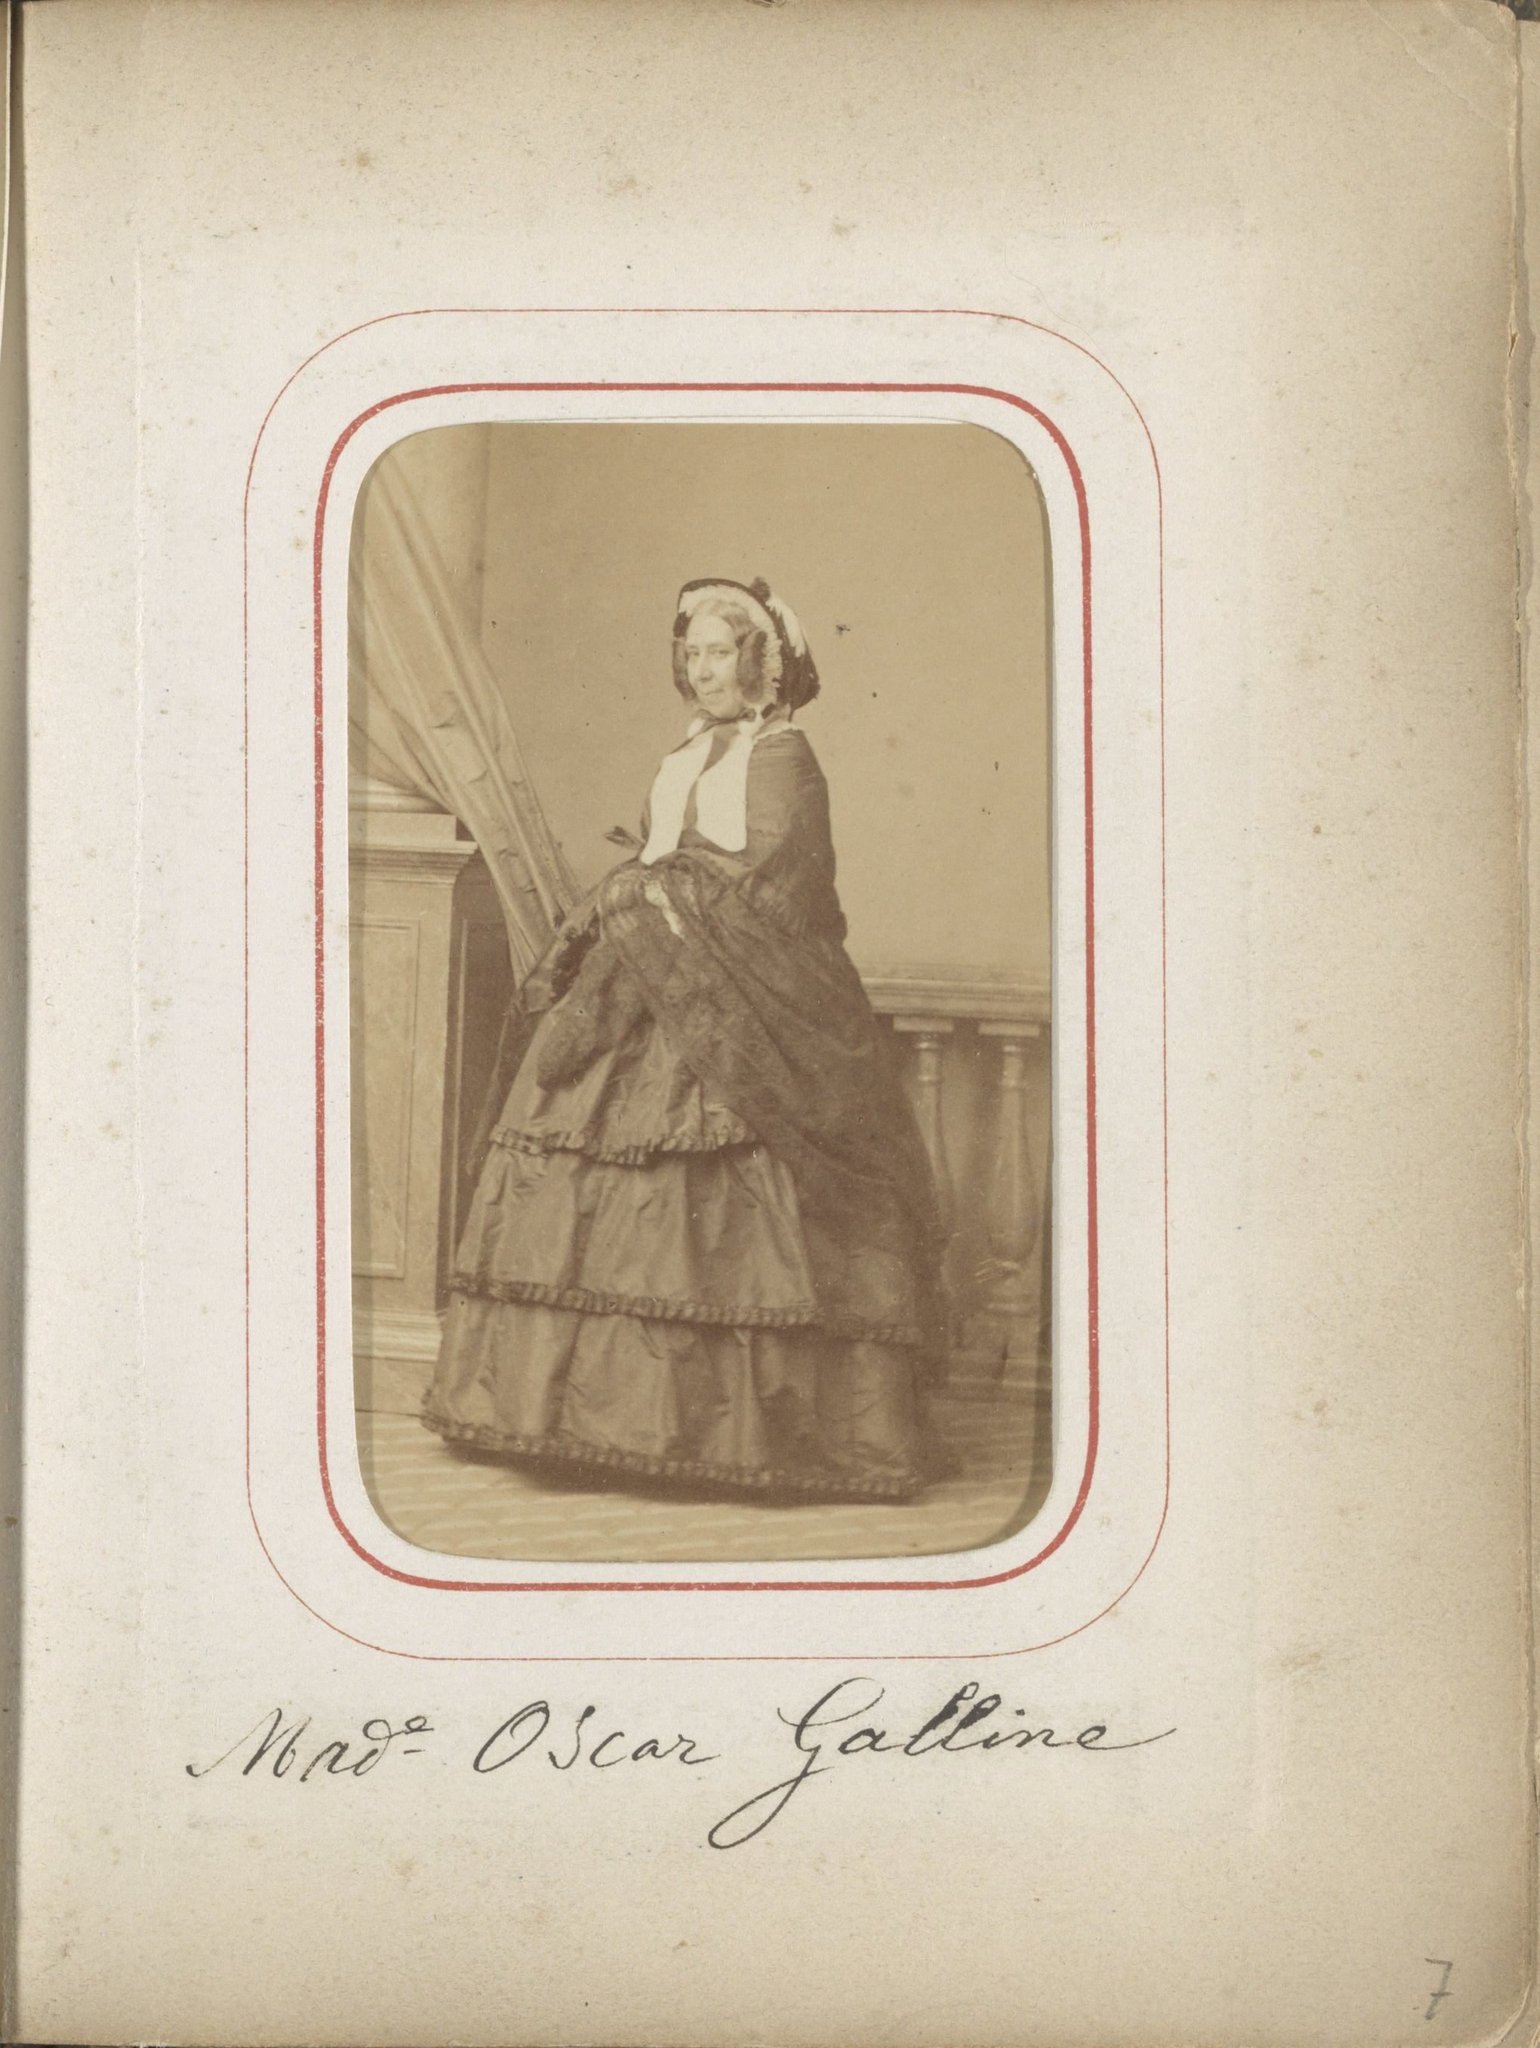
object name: carte de visite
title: Portret van mevrouw Oscar Galline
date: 1860-1861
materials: cardboard, paper, photographic support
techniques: albumen print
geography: paris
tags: studio requisites ~ photographer, historical persons, styles of hairdress - aa - ~ women, head-gear: hat, dress, gown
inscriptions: name: ‘Mad.e Oscar Gallone’, address: ‘8, Boulevart des Italiens, Paris’, inscription: ‘donnez par mr. Oscar Galline le 3 septembre 1861 après la mort de sa femme’